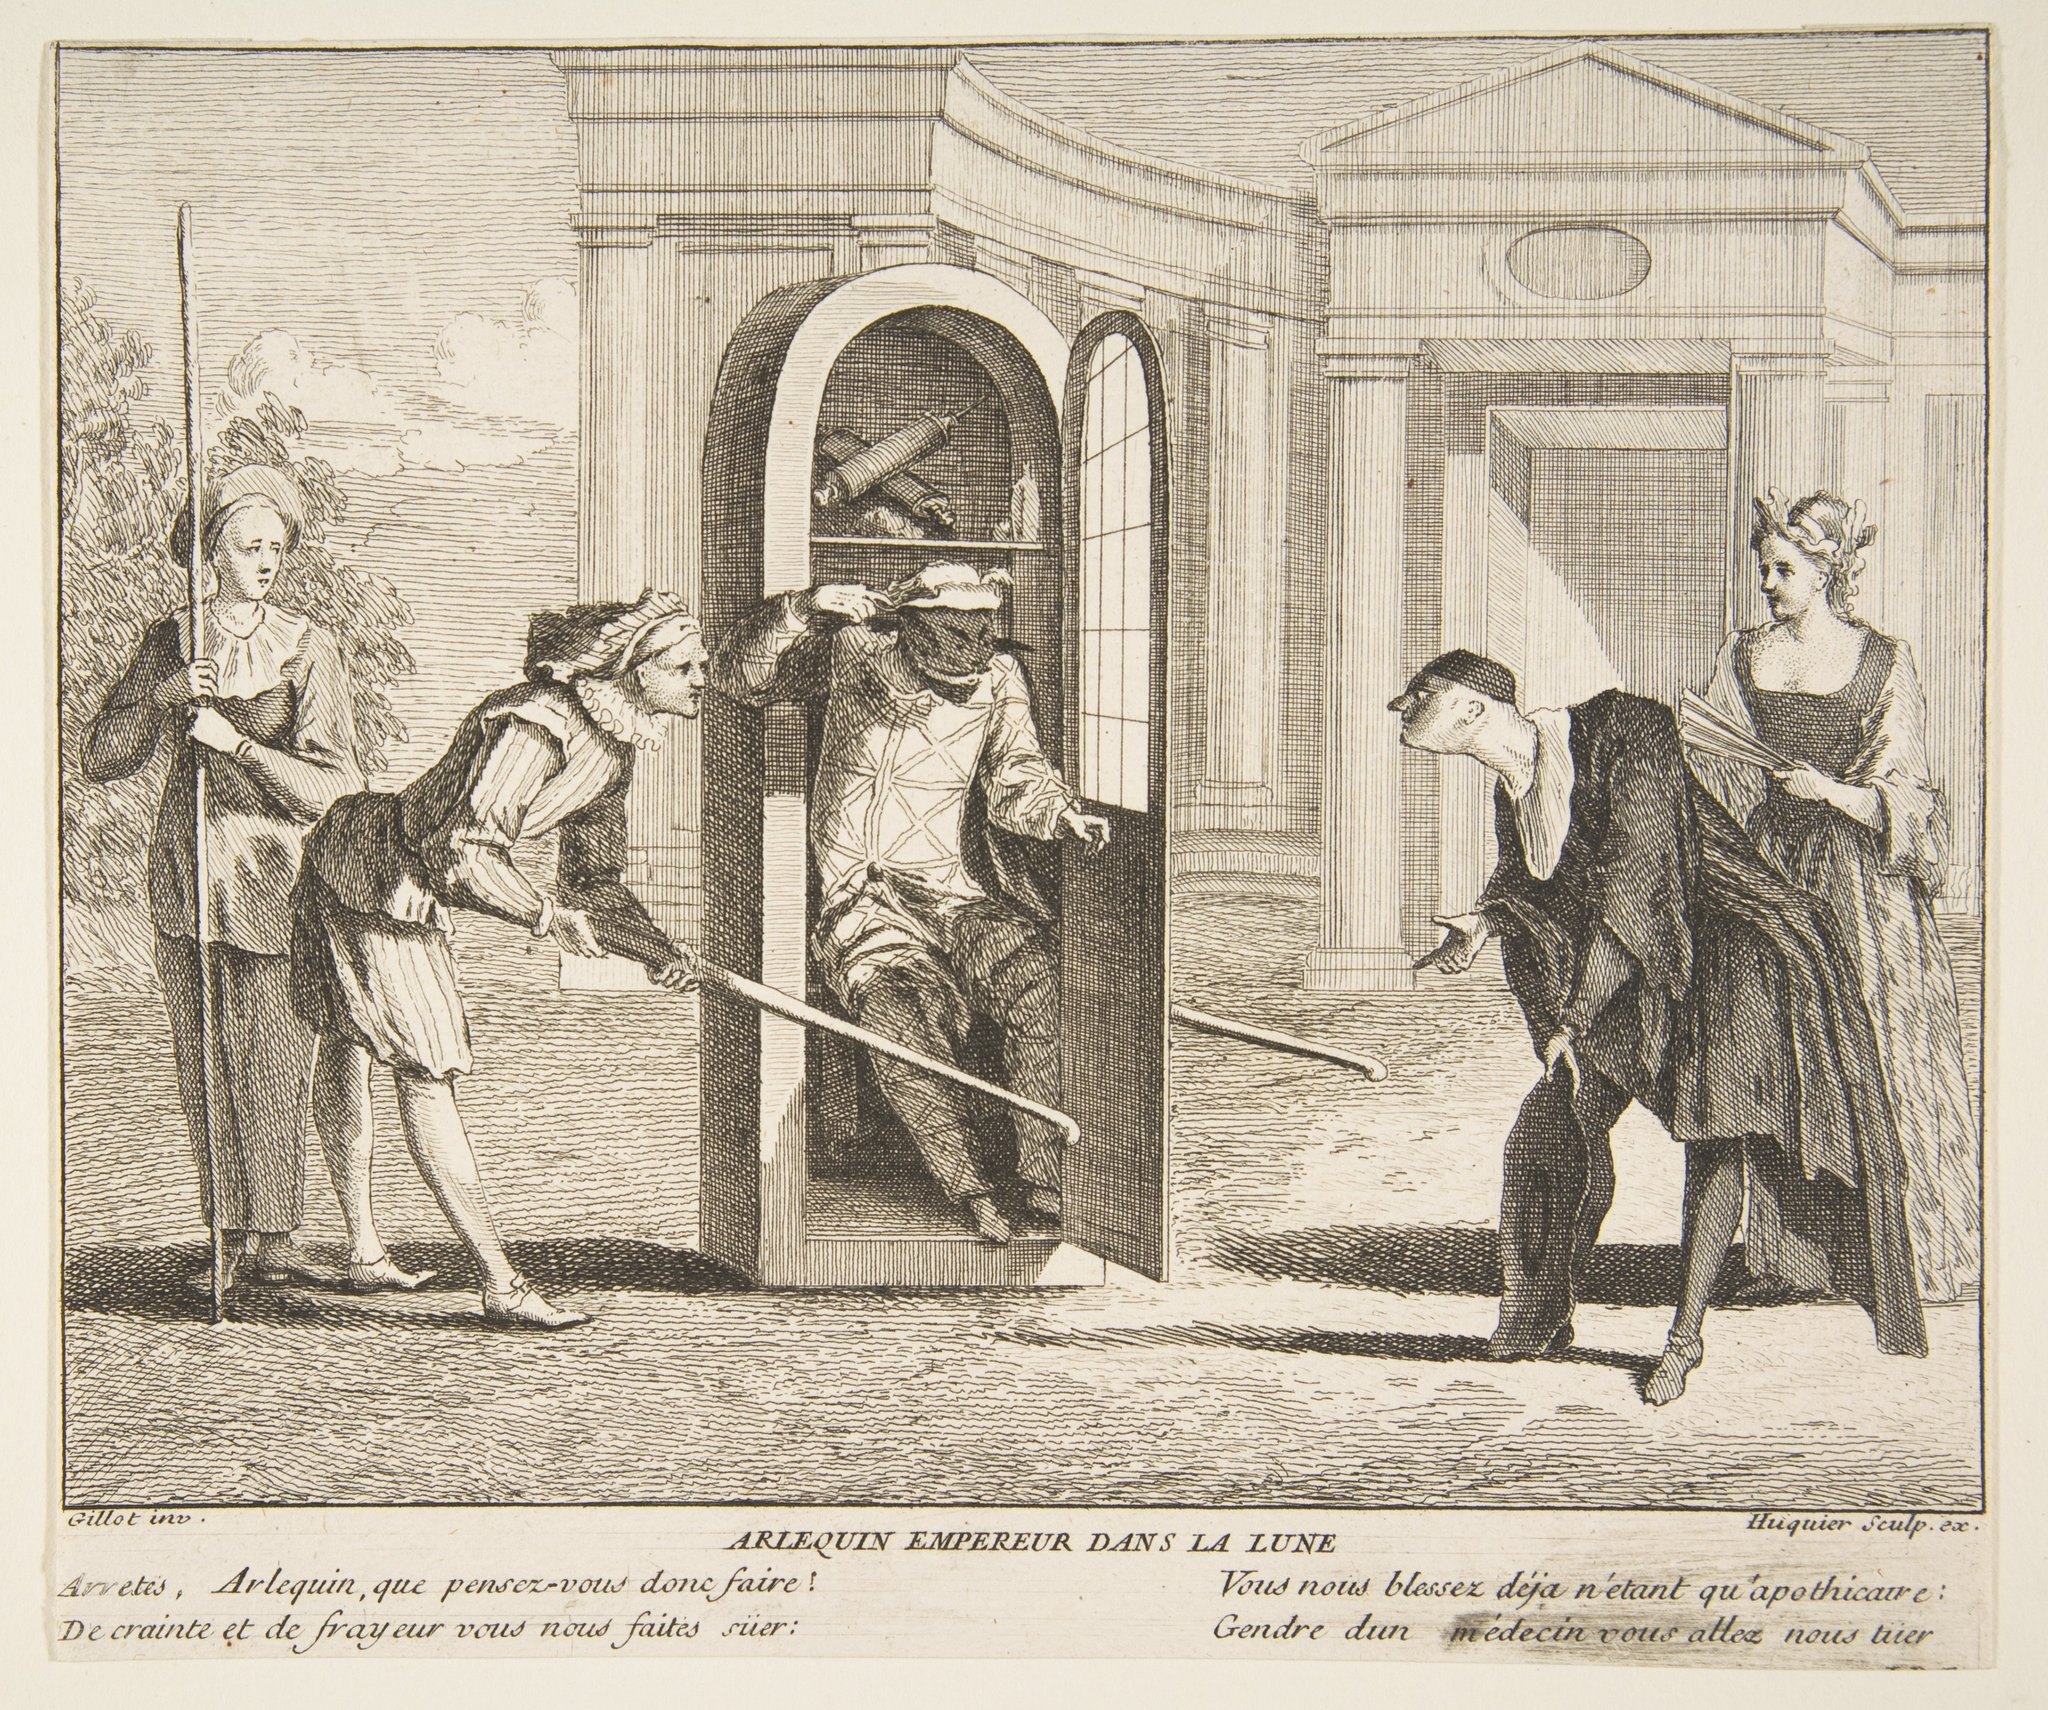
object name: print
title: Harlequin, Emperor on the Moon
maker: claude gillot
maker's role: artist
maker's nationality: french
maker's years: 1673-1722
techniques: etching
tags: men,women,clowns